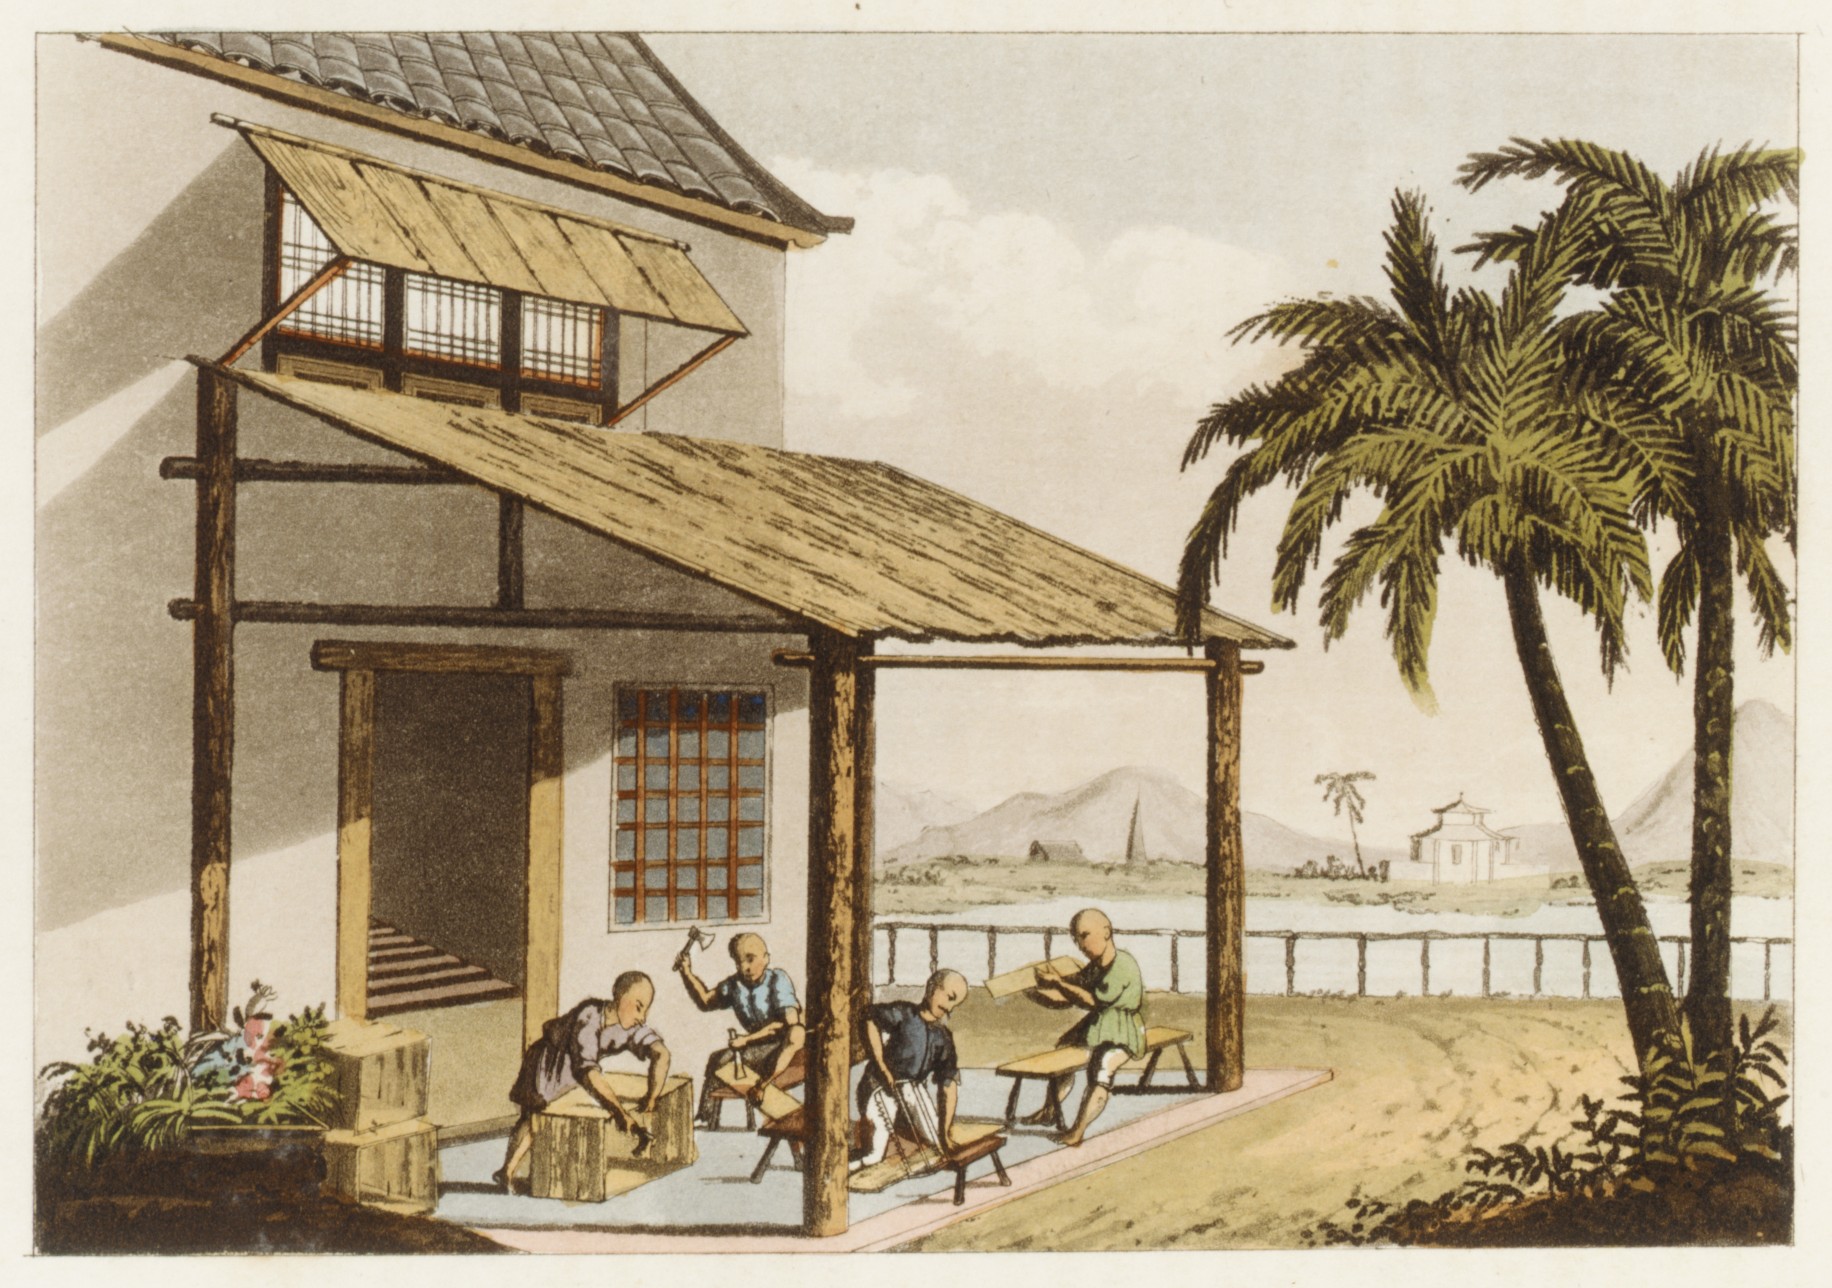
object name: book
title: The Repository of Arts, Literature, Fashions, Manufactuers, &c., 2nd series, volume 11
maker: rudolph ackermann, london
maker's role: publisher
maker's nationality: british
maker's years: 1794-1832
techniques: aquatint, engraving, etching, hand coloring, lithograph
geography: england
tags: houses,men,trees,working